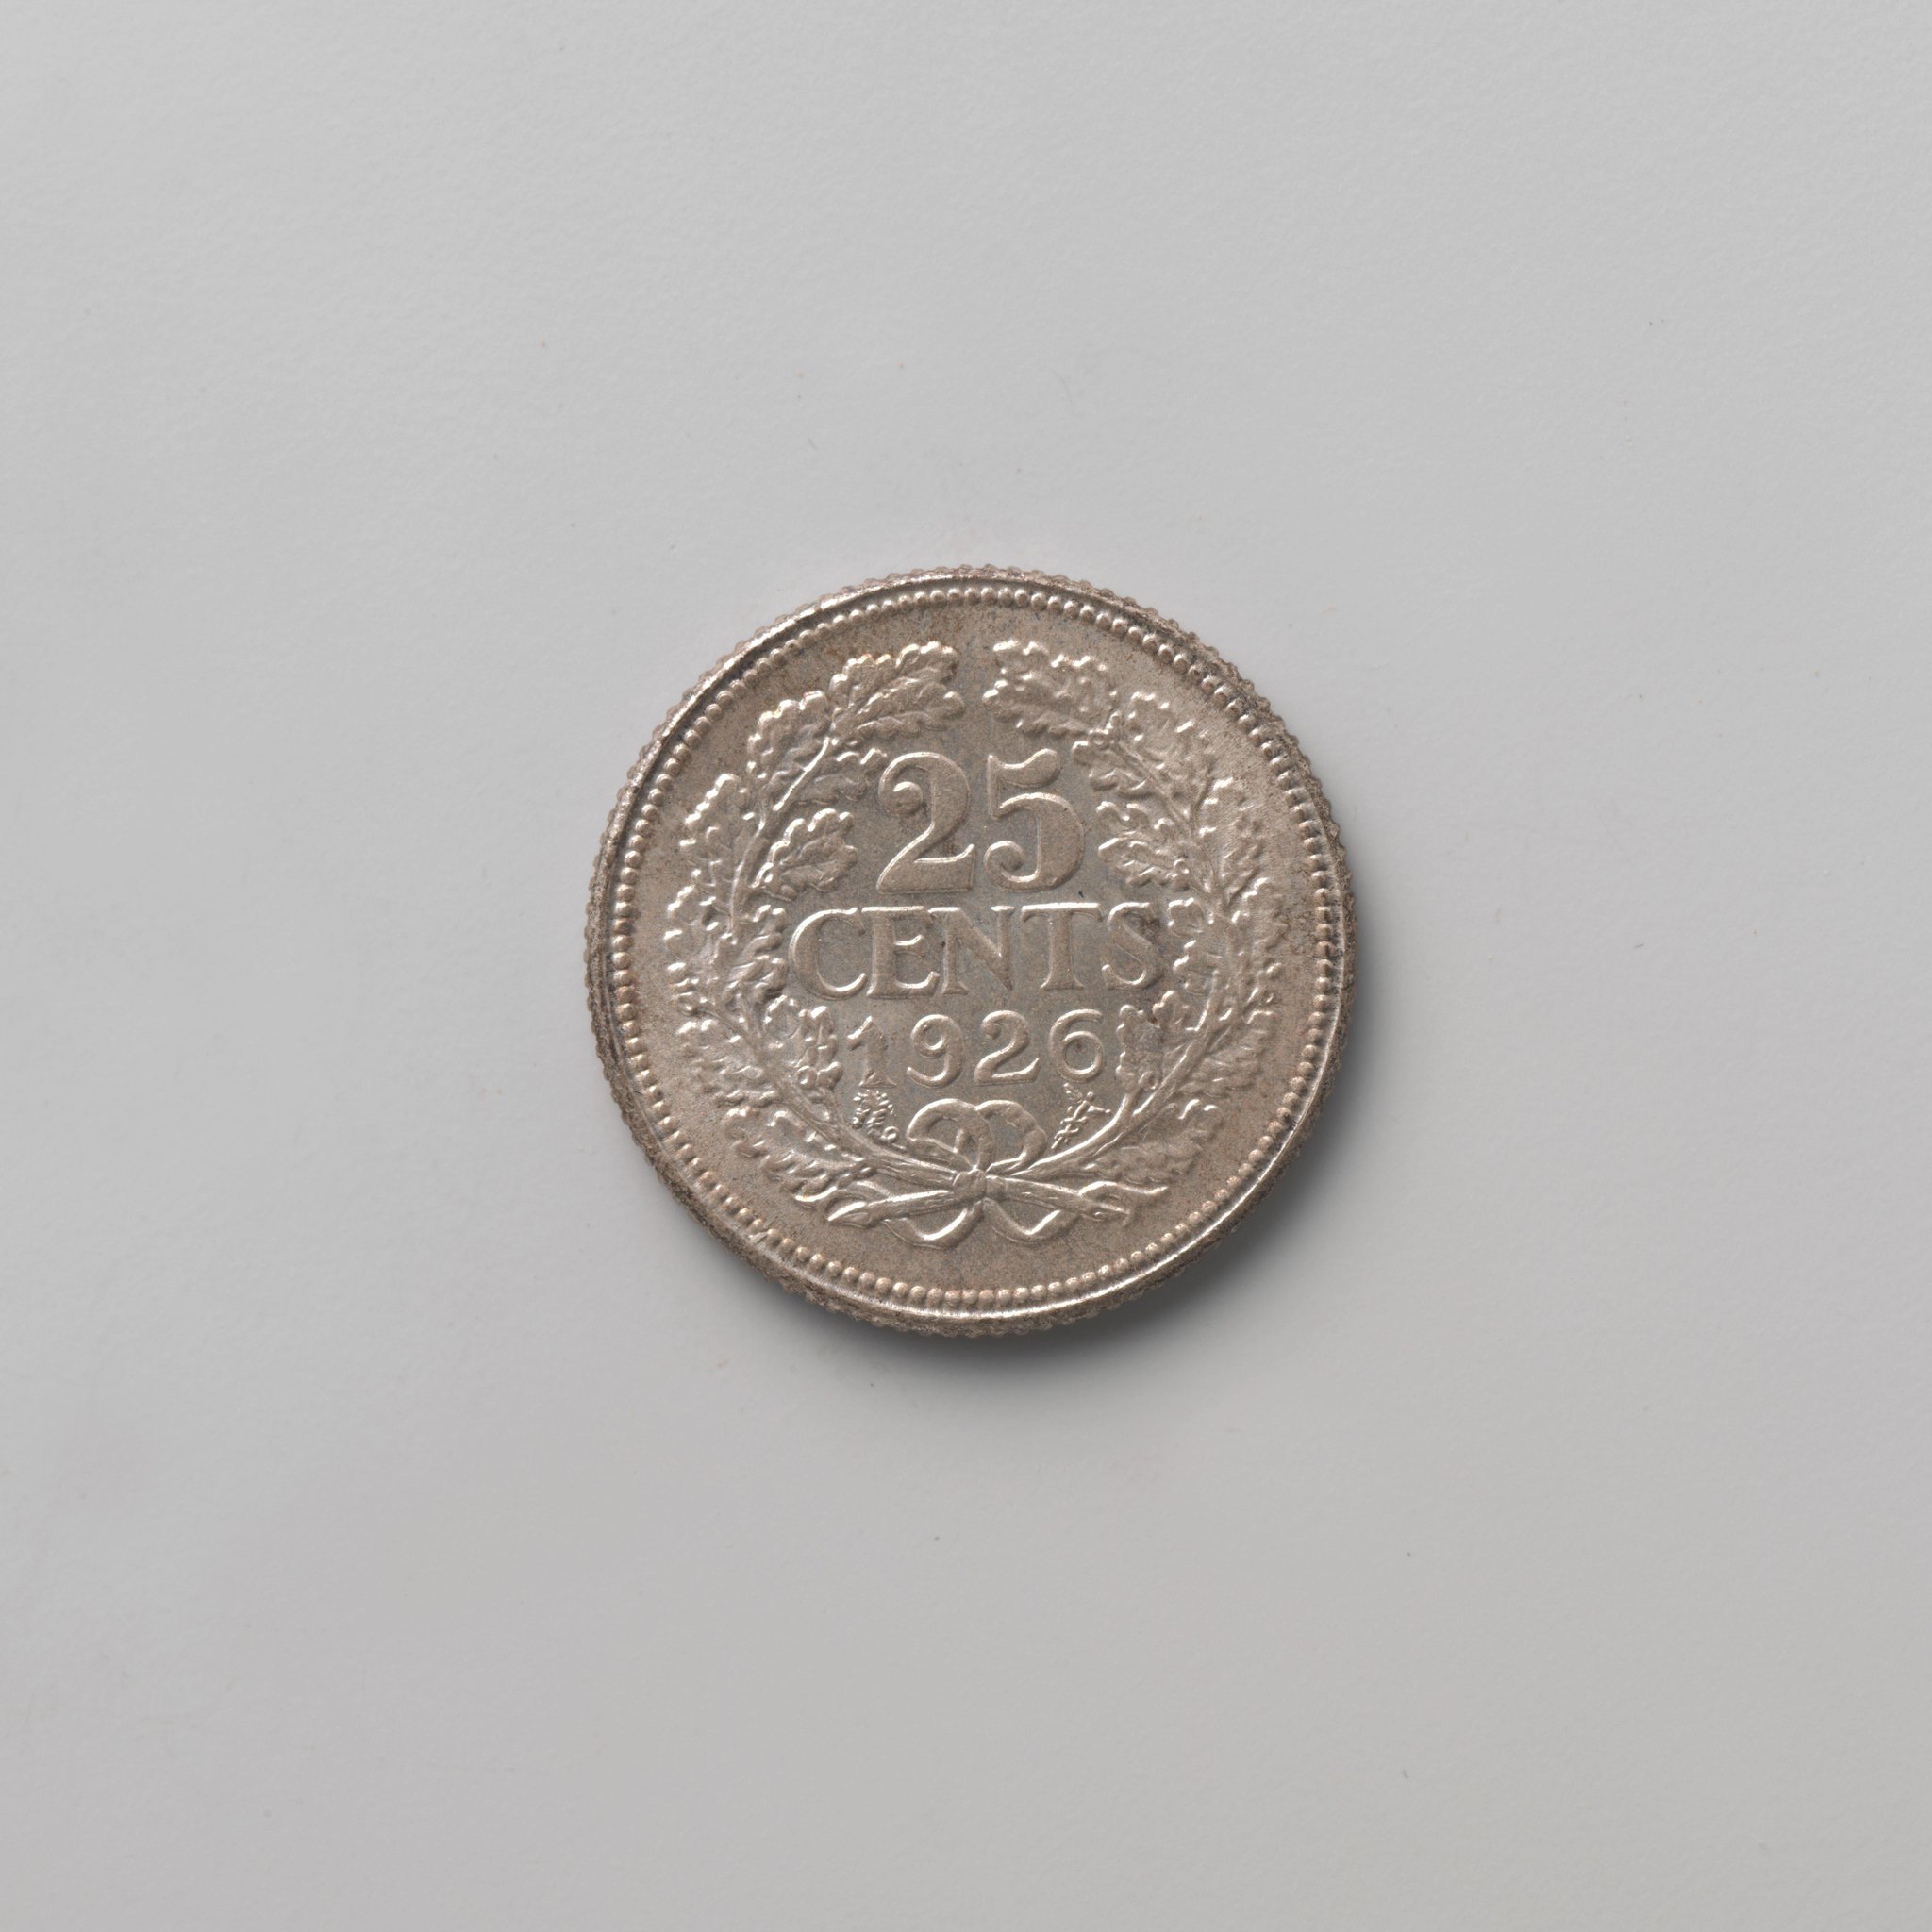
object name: coin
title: Nederlandse 25 cent,1926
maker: wilhelmina of the netherlands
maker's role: print maker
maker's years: 1880-1962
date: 1926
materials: silver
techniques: striking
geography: utrecht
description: Zilveren munt. Voorzijde: hoofd naar links. Keerzijde: binnen twee samengebonden eiketakken waarde-aanduiding 25 cents en jaartal. Kartelrand.